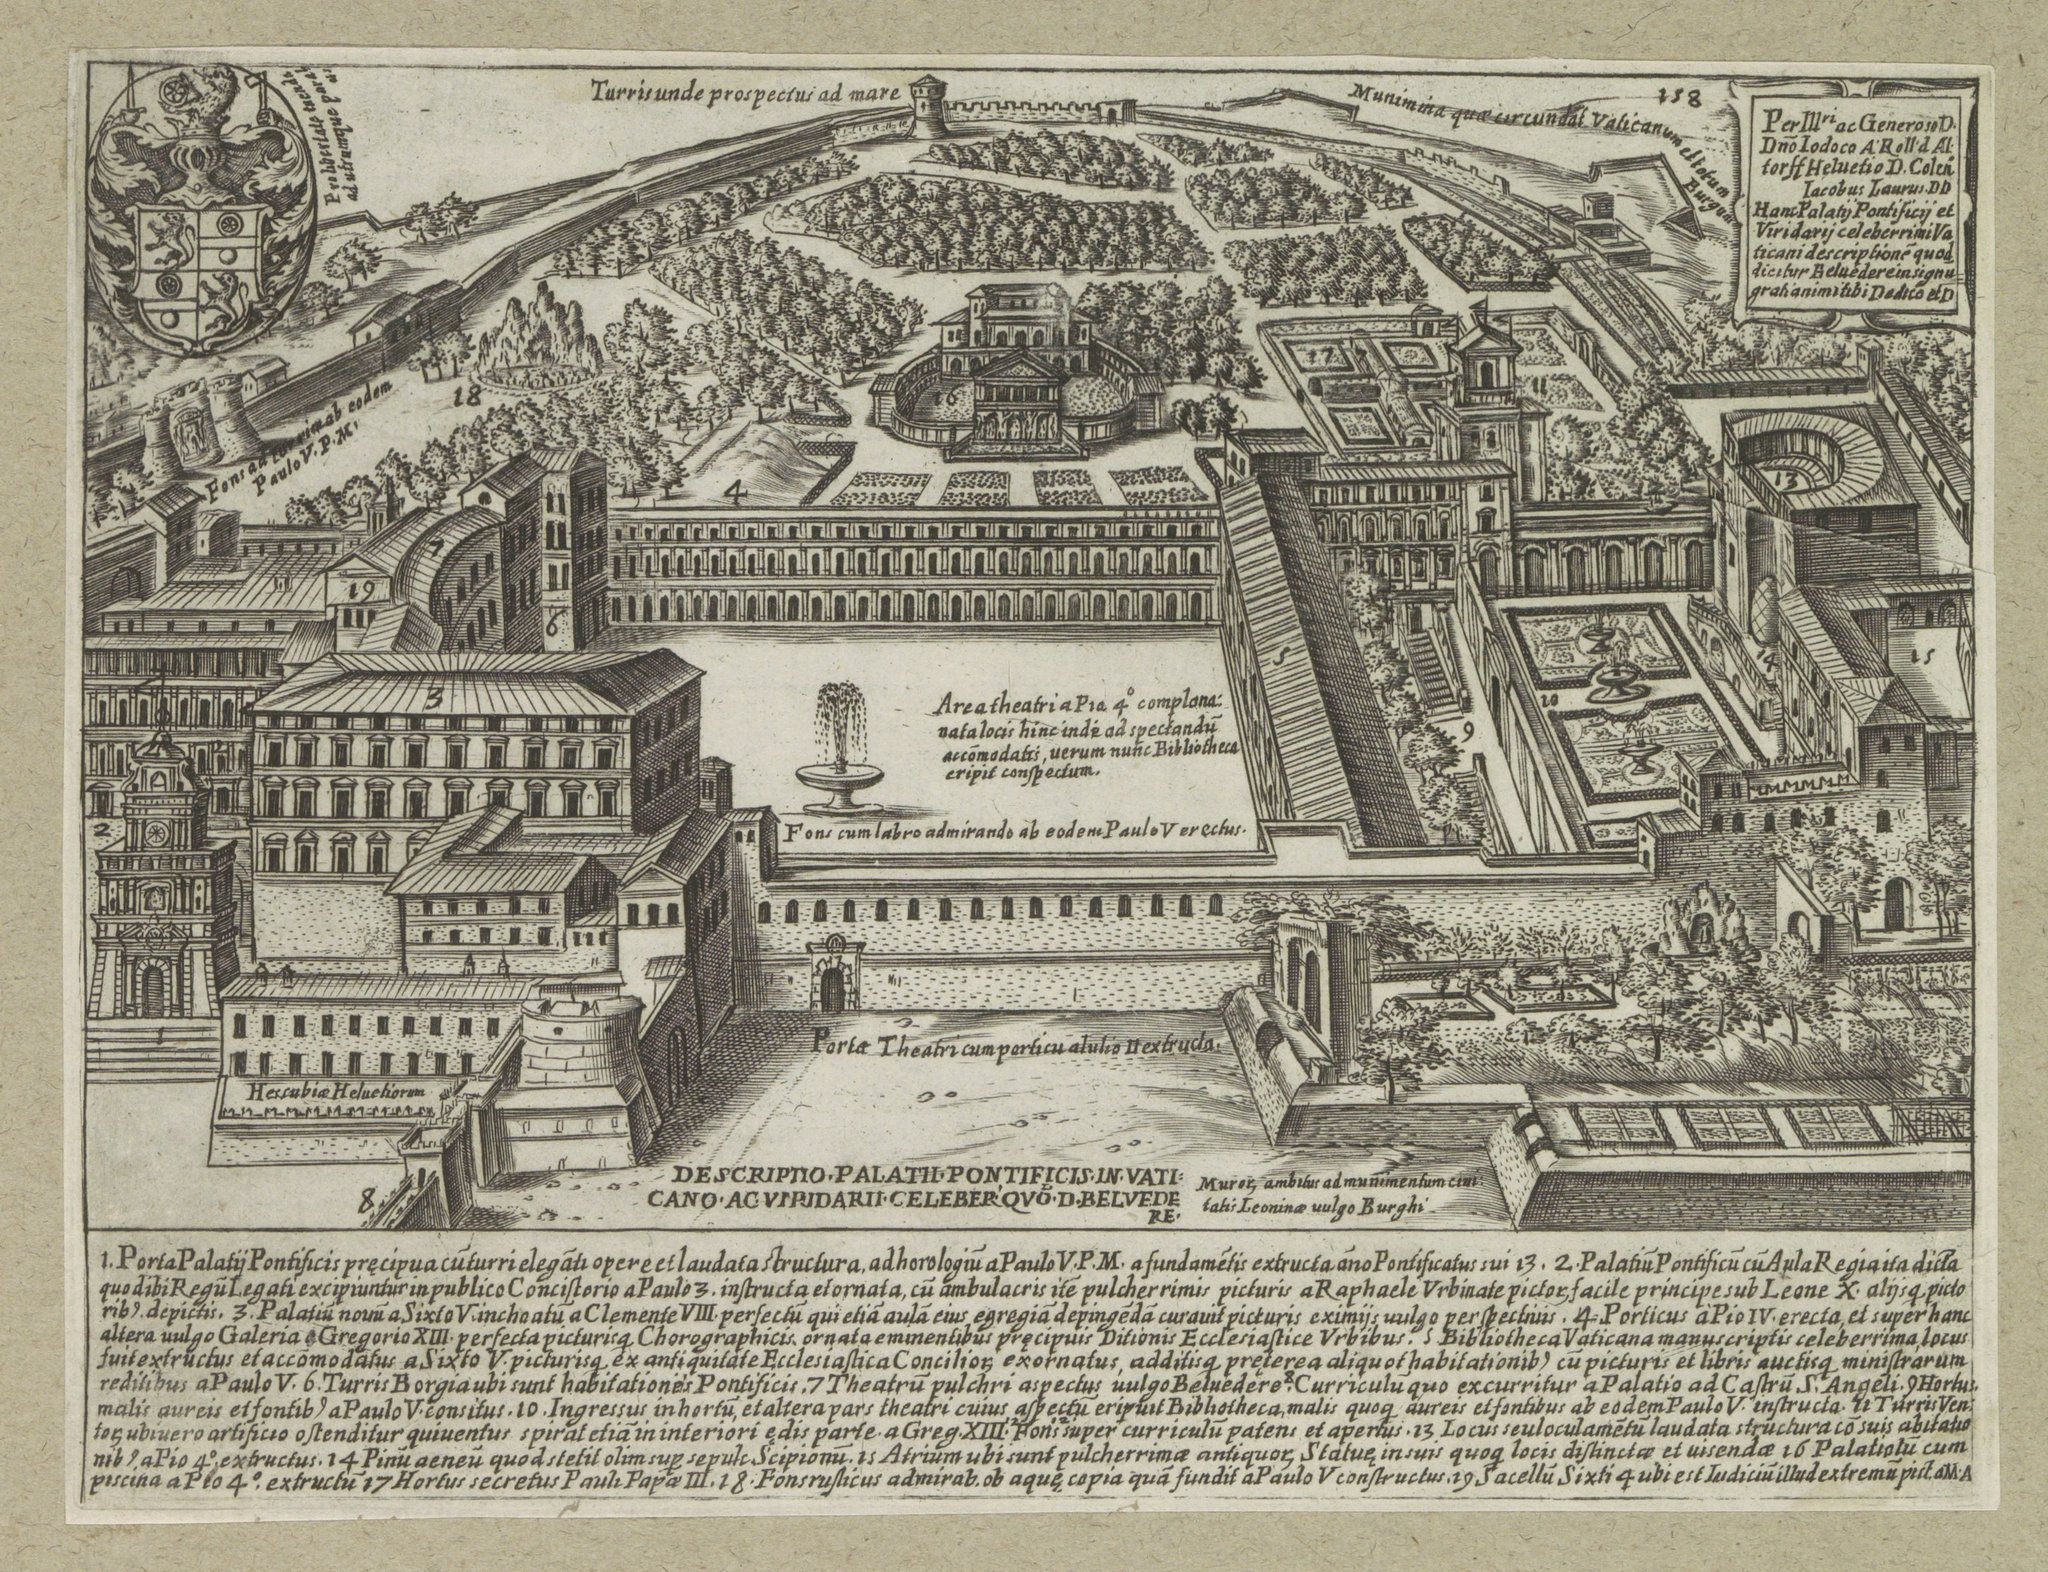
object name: print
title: Antiquae Urbis Splendor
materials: paper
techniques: etching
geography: italy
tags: garden, palace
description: Deze prent maakt deel uit van een set van 158 prenten (+ titelprenten), die verscheen in vier delen. In 1612 verschenen delen één en twee. In 1615 verscheen het derde deel en in 1628 verscheen deel vier. In 1637 publiceerde Vitale Mascardi de eerste heruitgave van de gehele set met nummering.